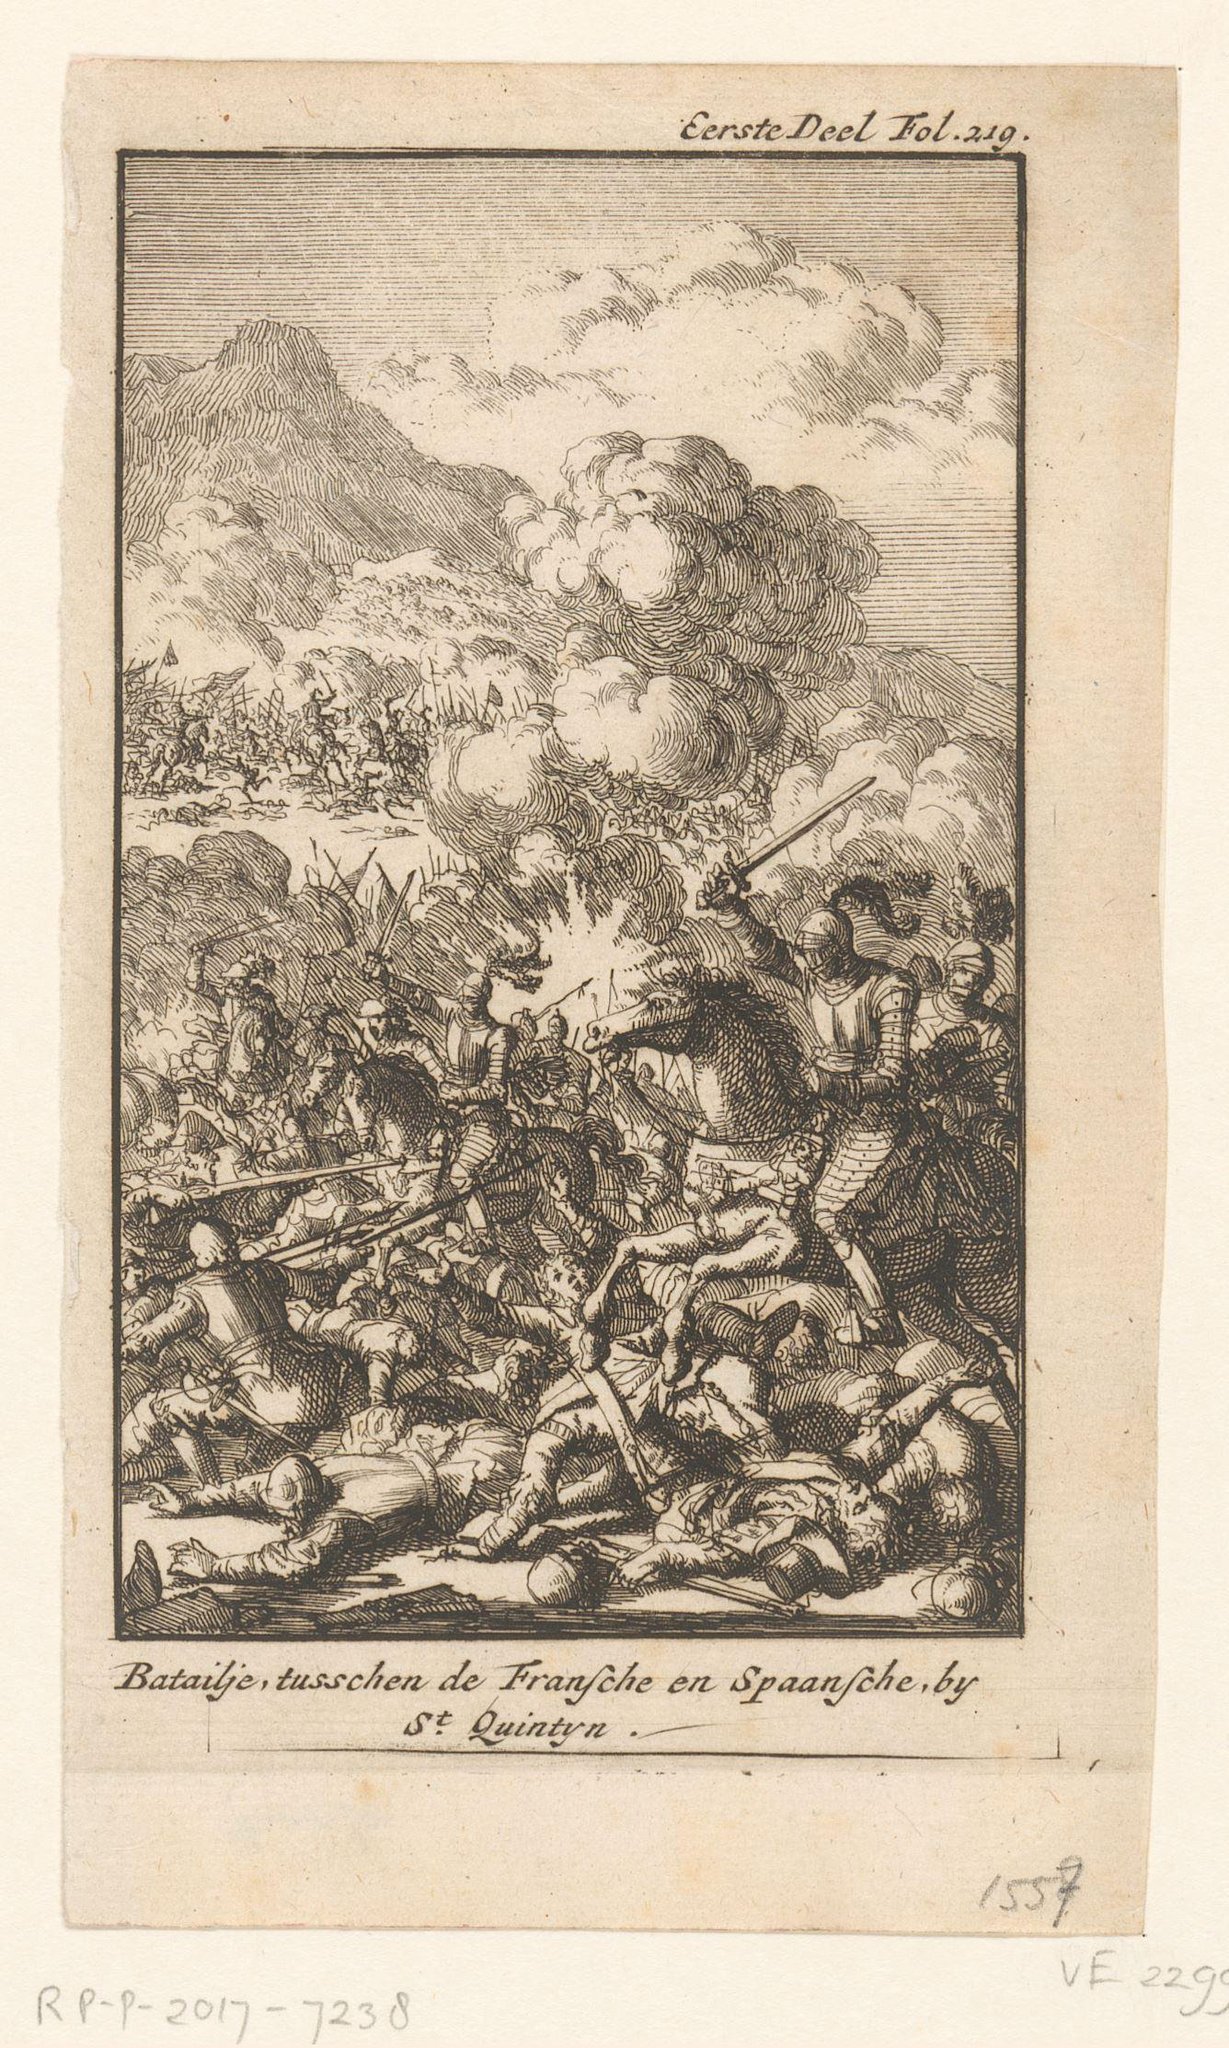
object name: book illustration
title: Batailje, tusschen de Fransche en Spaansche by St. Quintyn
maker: jan luyken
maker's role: draughtsman, print maker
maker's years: 1649-1712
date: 1699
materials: paper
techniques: etching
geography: netherlands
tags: philip ii of spain, battle, fighting in general (+ land forces)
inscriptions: collector's mark: Lugt 2228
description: Gebruikt als illustratie in: Leti, Gregorio. Het Leven van Filips de II, Koning van Spanien. Vertaald door N.J. Wieringa. Den Haag: Engelbreght Boucquet, 1699, dl.1, f. 219.